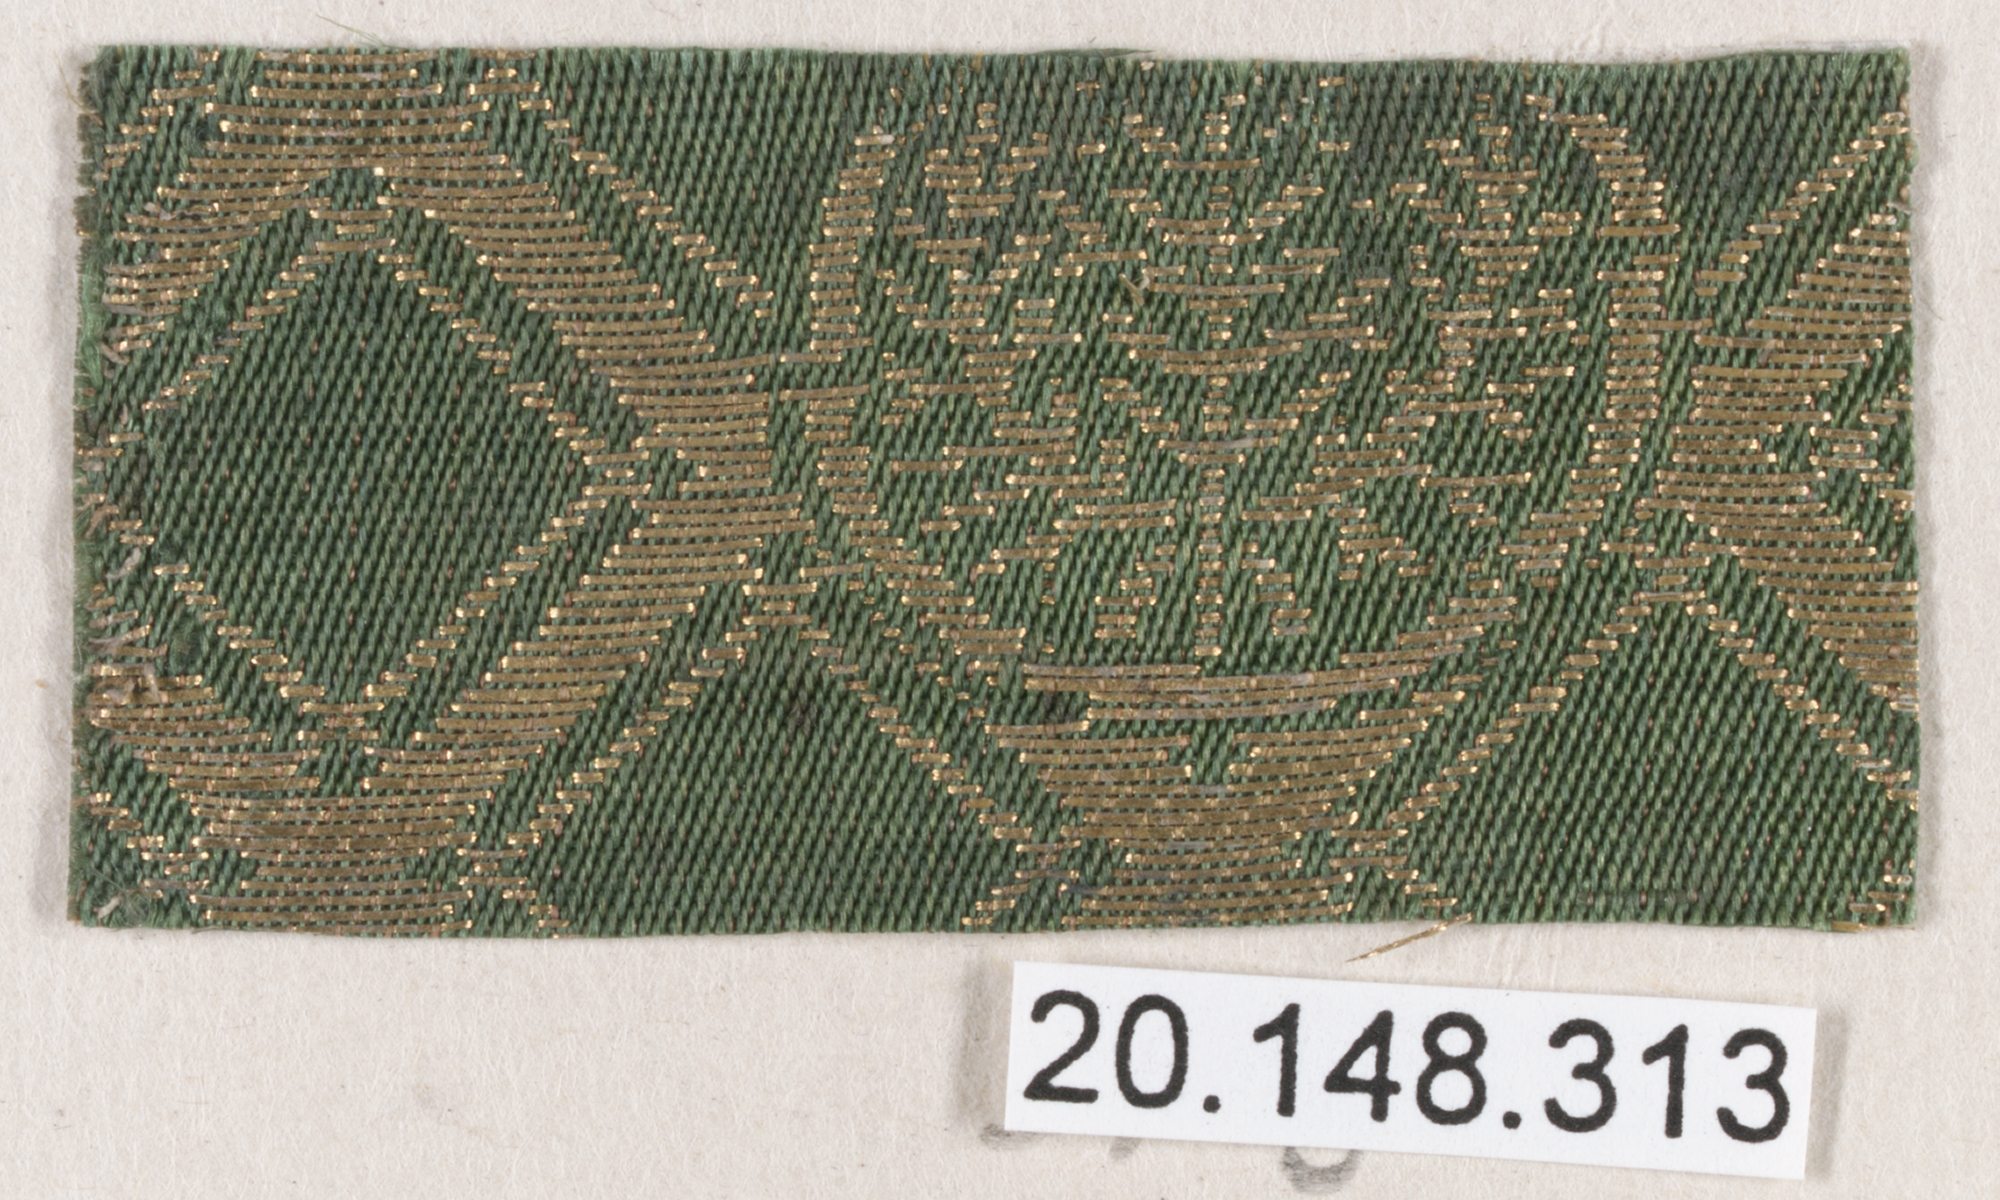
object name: piece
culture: japanese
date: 1601-1700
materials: silk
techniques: compound weave